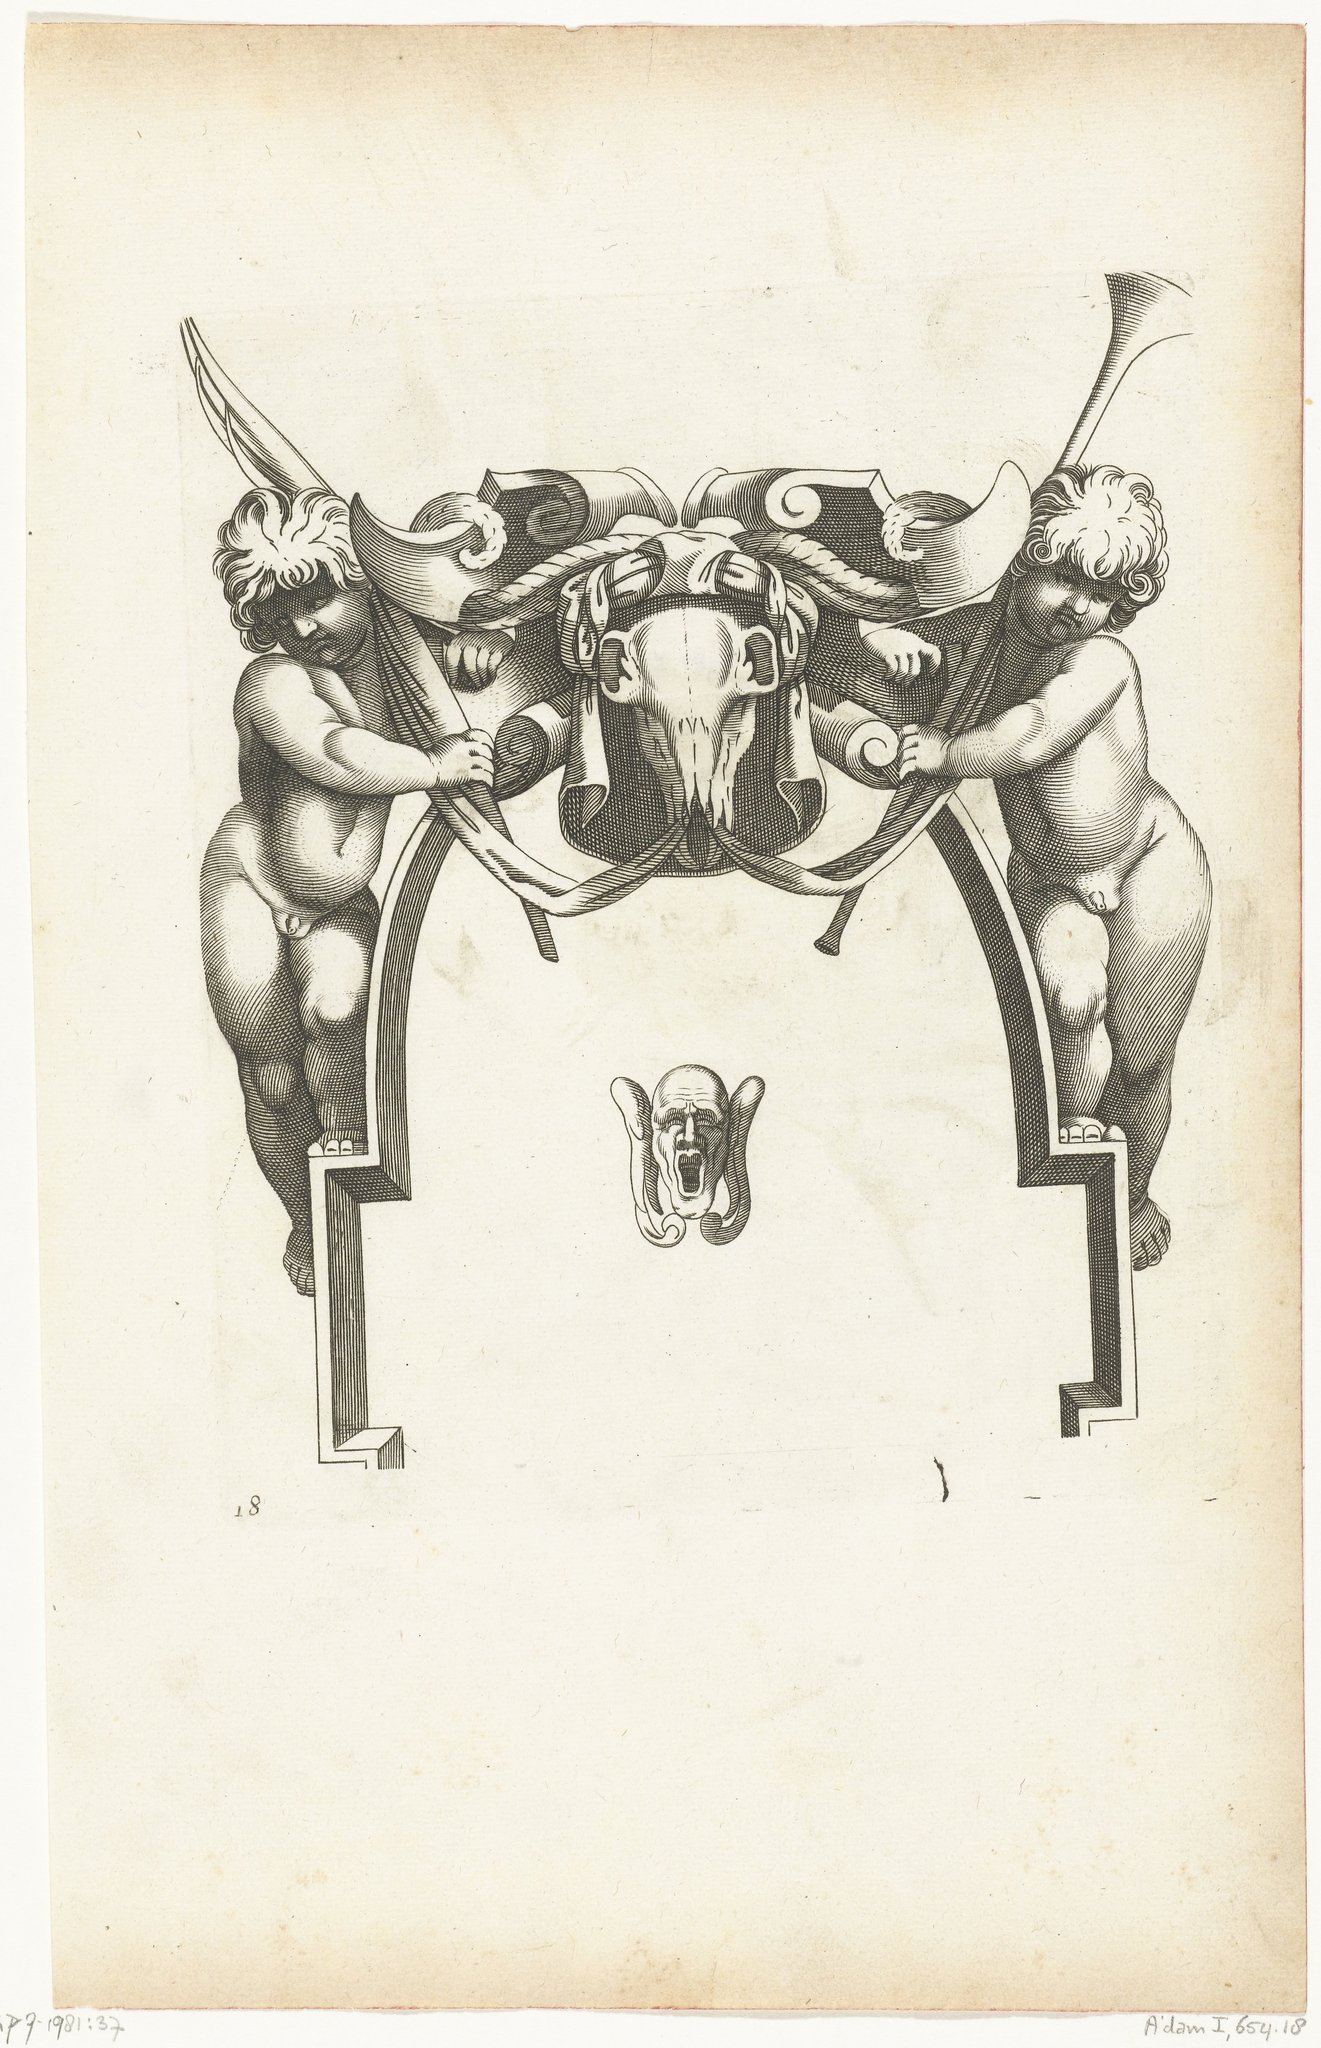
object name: print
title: Deurstuk geflankeerd door twee kinderen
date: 1613-1657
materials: paper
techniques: engraving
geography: france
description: Midden boven hangt een dierenschedel, in het midden zweeft een mascaron.